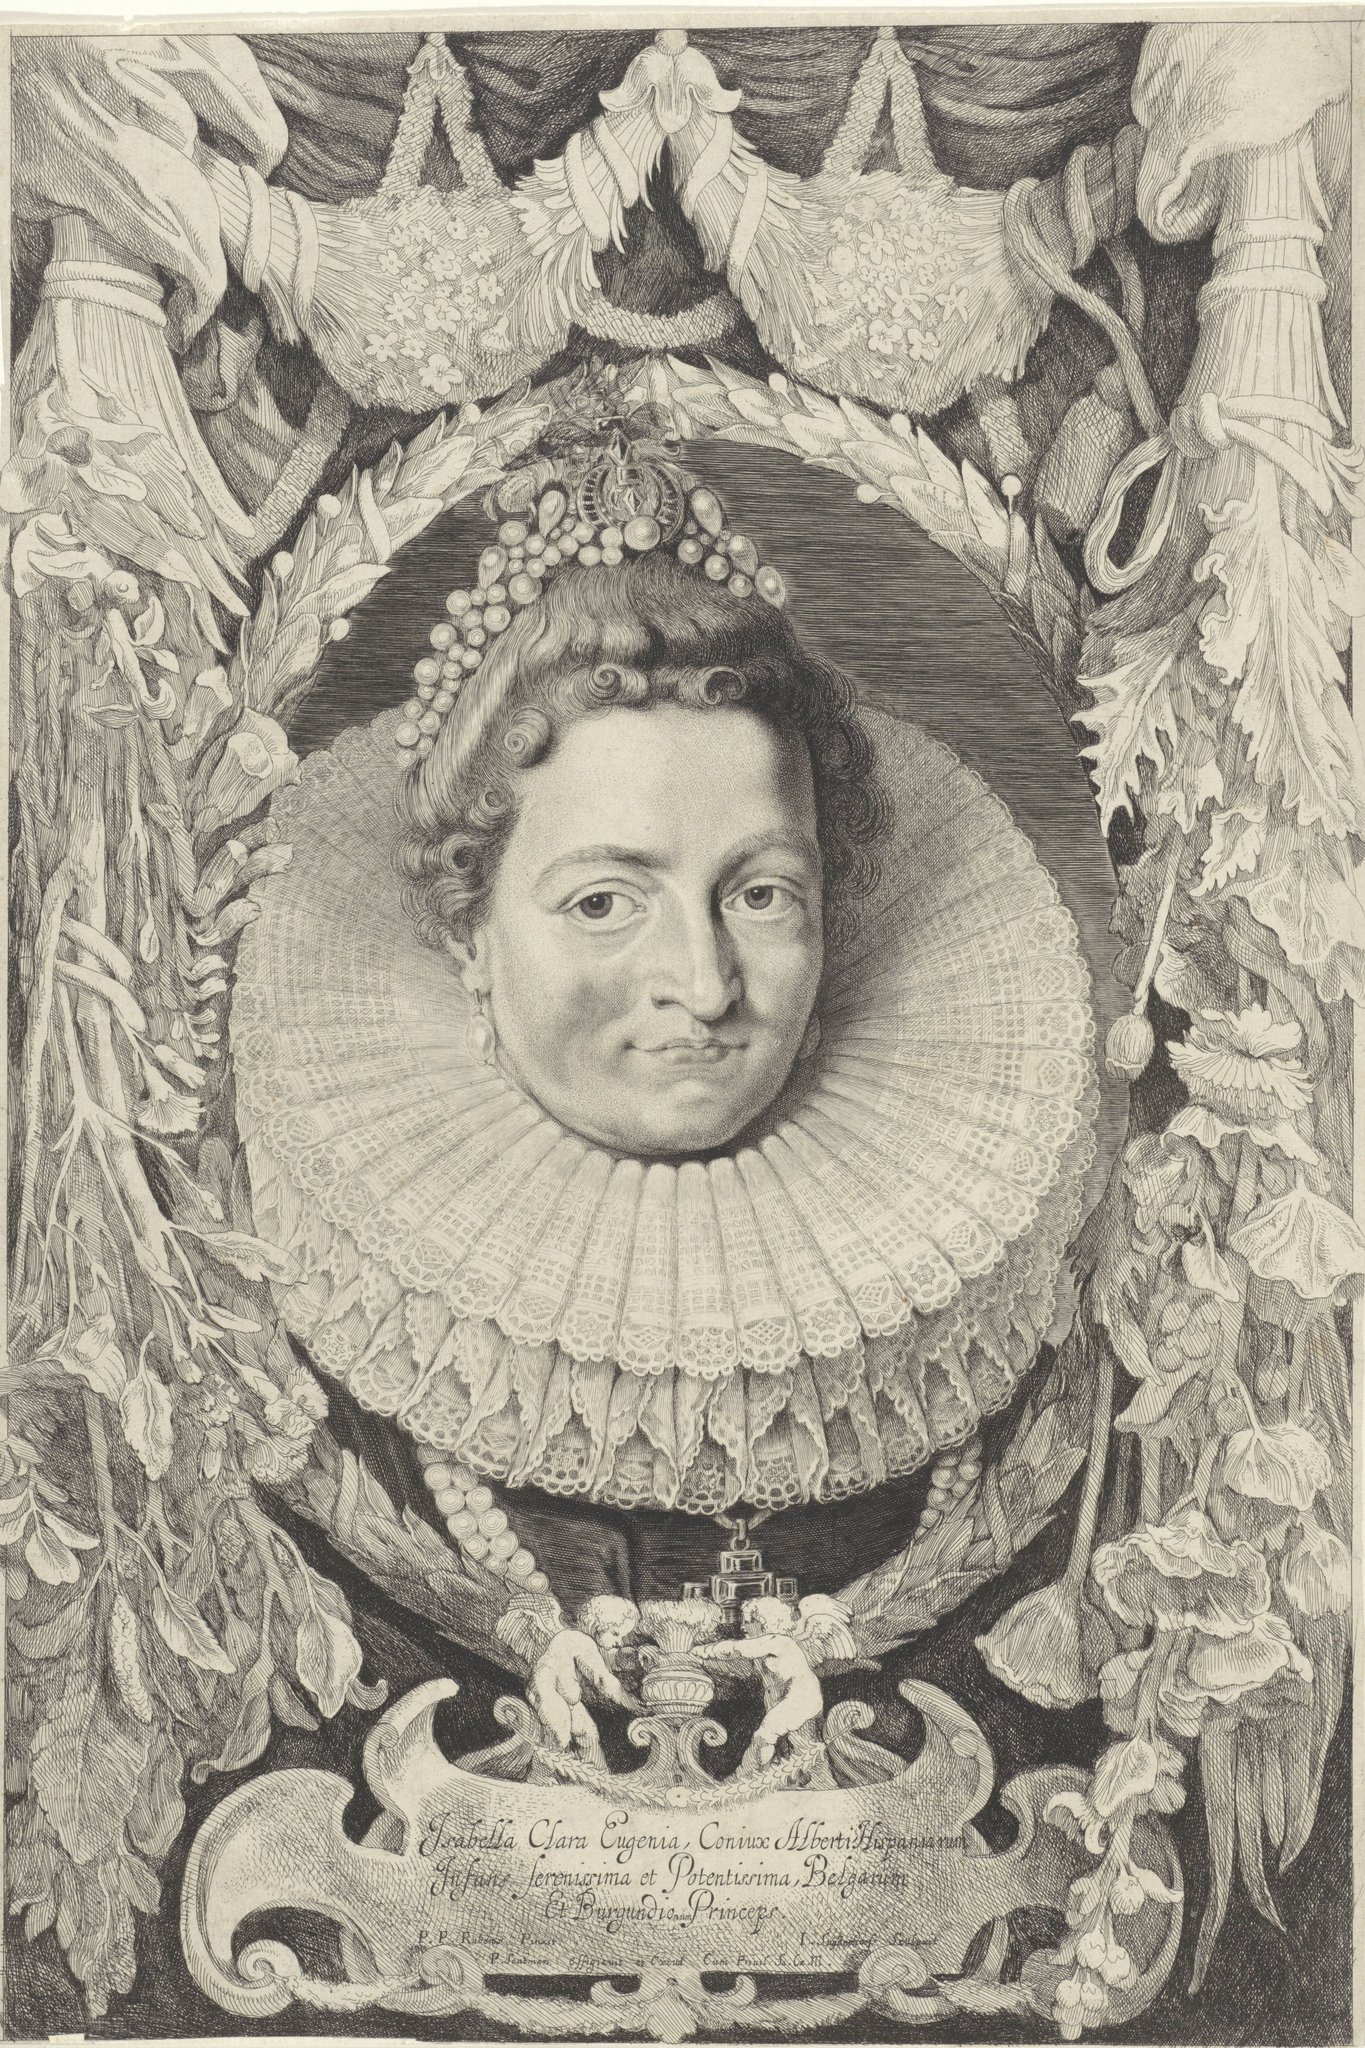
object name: print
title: Portret van Isabella Clara Eugenia, infante van Spanje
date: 1644-1650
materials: paper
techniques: engraving, etching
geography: haarlem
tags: infante van spanje isabella clara eugenia, ornament ~ festoon, garland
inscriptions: collector's mark: Lugt 240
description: Portret van Isabella Clara Eugenia, infante van Spanje. Het portret is gevat in een ornamentele omlijsting met guirlandes van bladeren en bloemen. Midden onder een cartouche met haar naam en titel in het Latijn.